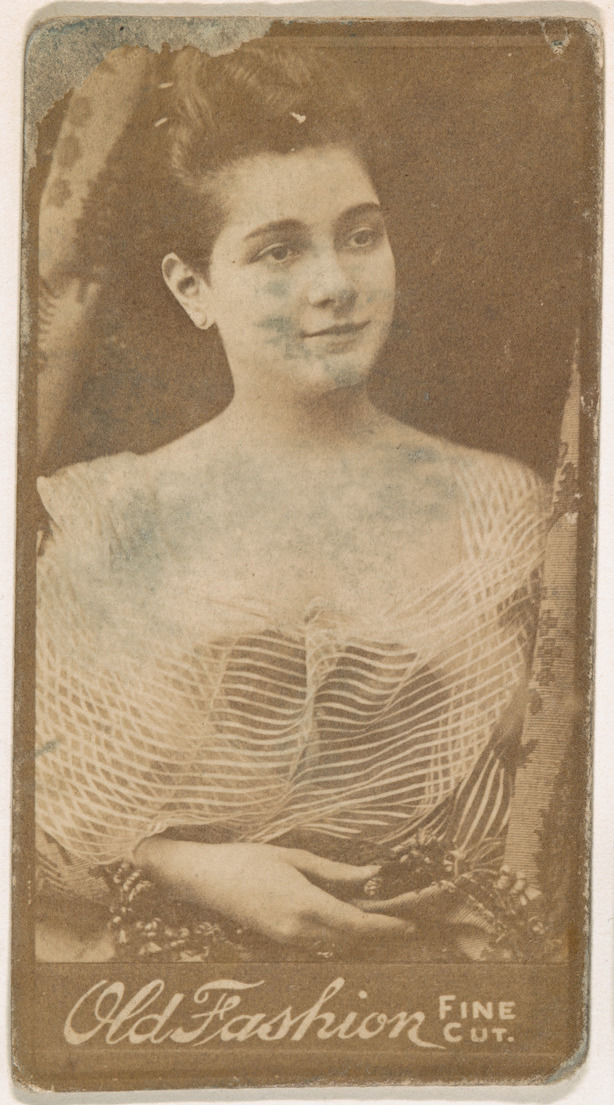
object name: photograph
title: Actress wearing striped blouse, from the Actresses series (N664) promoting Old Fashion Fine Cut Tobacco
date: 1888-1890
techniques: albumen silver print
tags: portraits,women,actresses